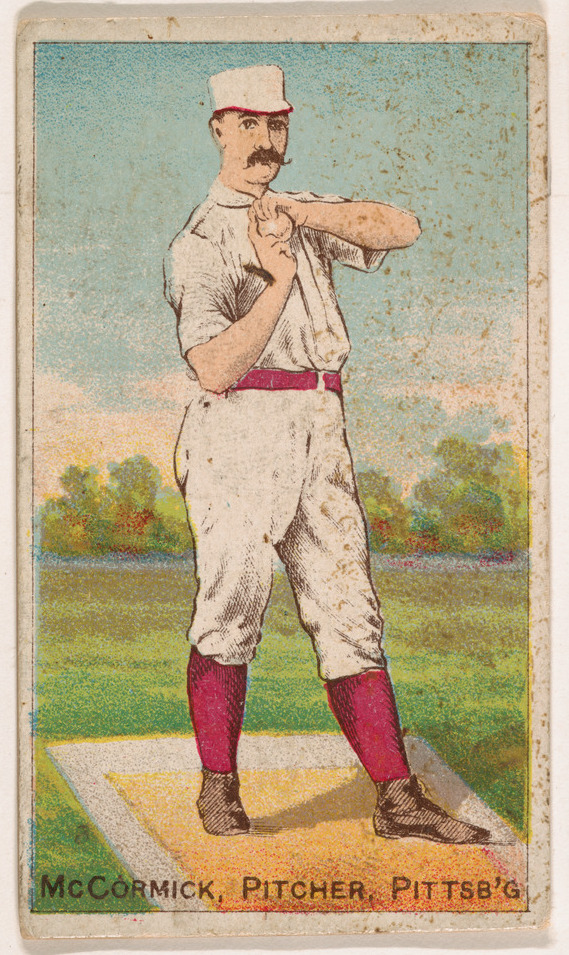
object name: baseball card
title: McCormick, Pitcher, Pittsburgh, from the Gold Coin series (N284) for Gold Coin Chewing Tobacco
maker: d. buchner & co., new york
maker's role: publisher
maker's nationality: american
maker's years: 1850-1900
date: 1887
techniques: color lithograph, drawing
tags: men,baseball,athletes